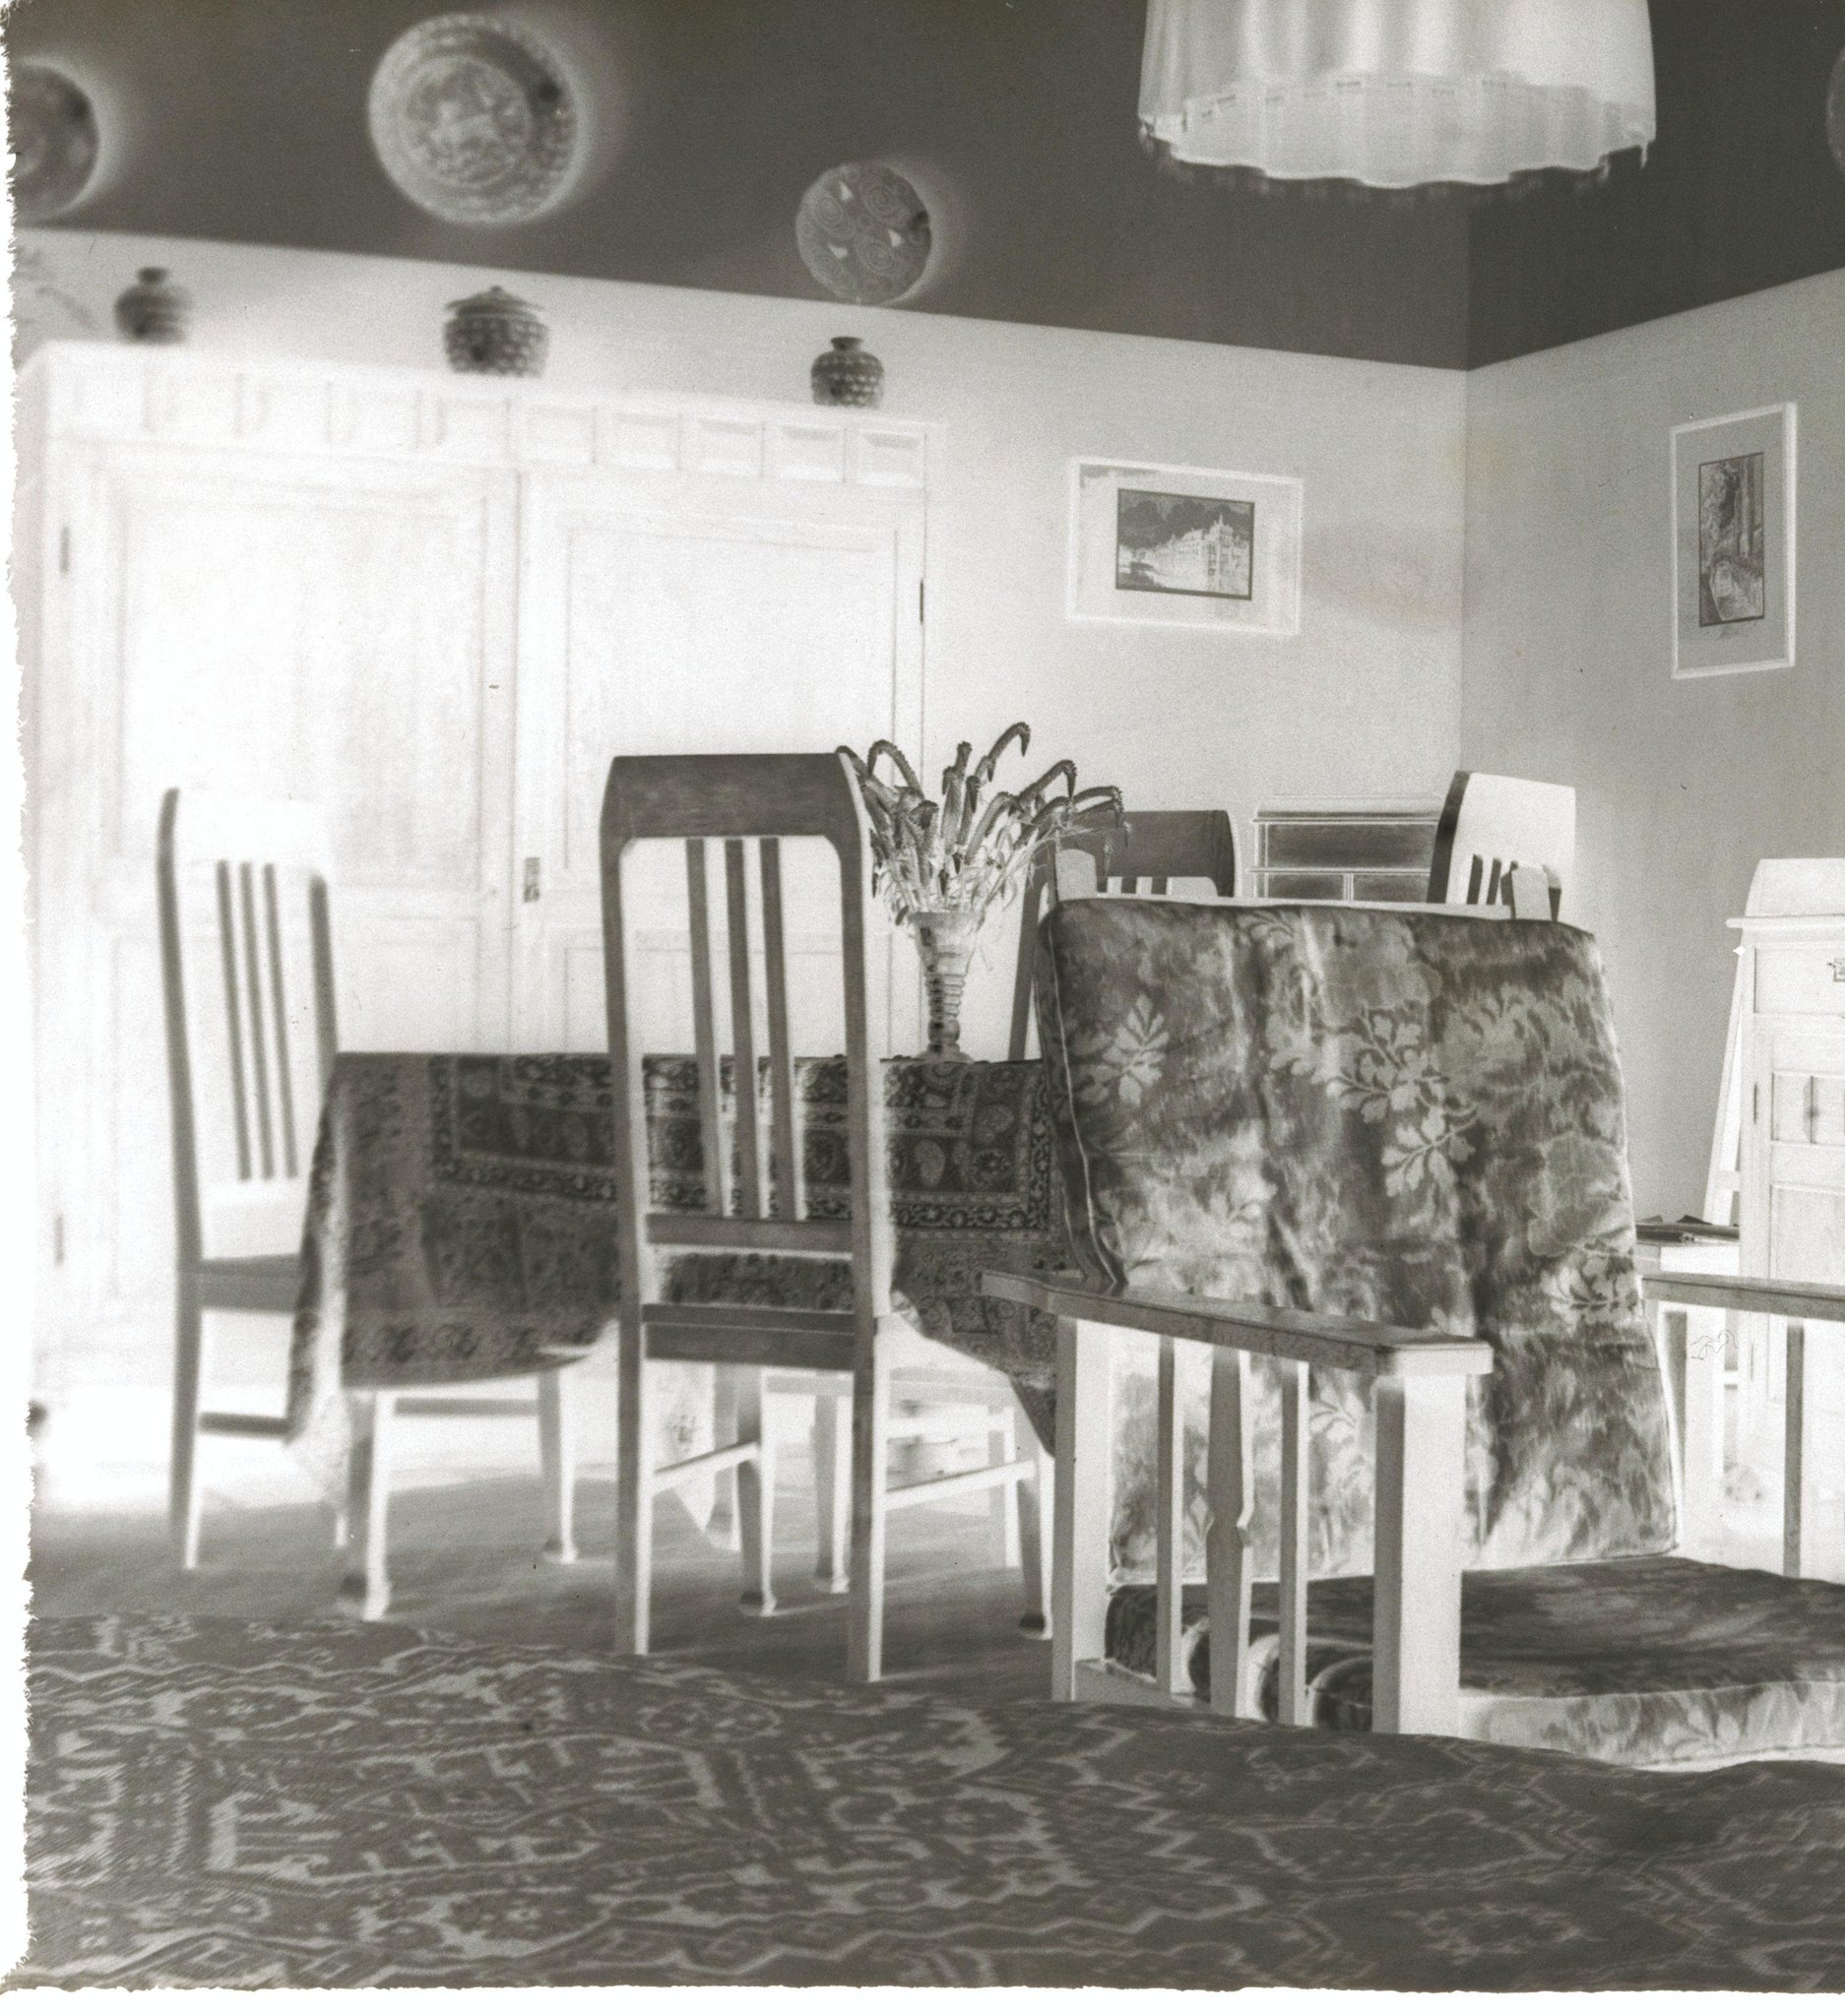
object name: negative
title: Kamer met meubels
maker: Anonymous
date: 1928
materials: film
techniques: gelatin silver negative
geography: dutch east indies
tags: interior of the house, dutch east indies, the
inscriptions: number: ‘9’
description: Onderdeel van Kodak negatievenalbum met 35 foto's van een familie in Nederlands-Indië.